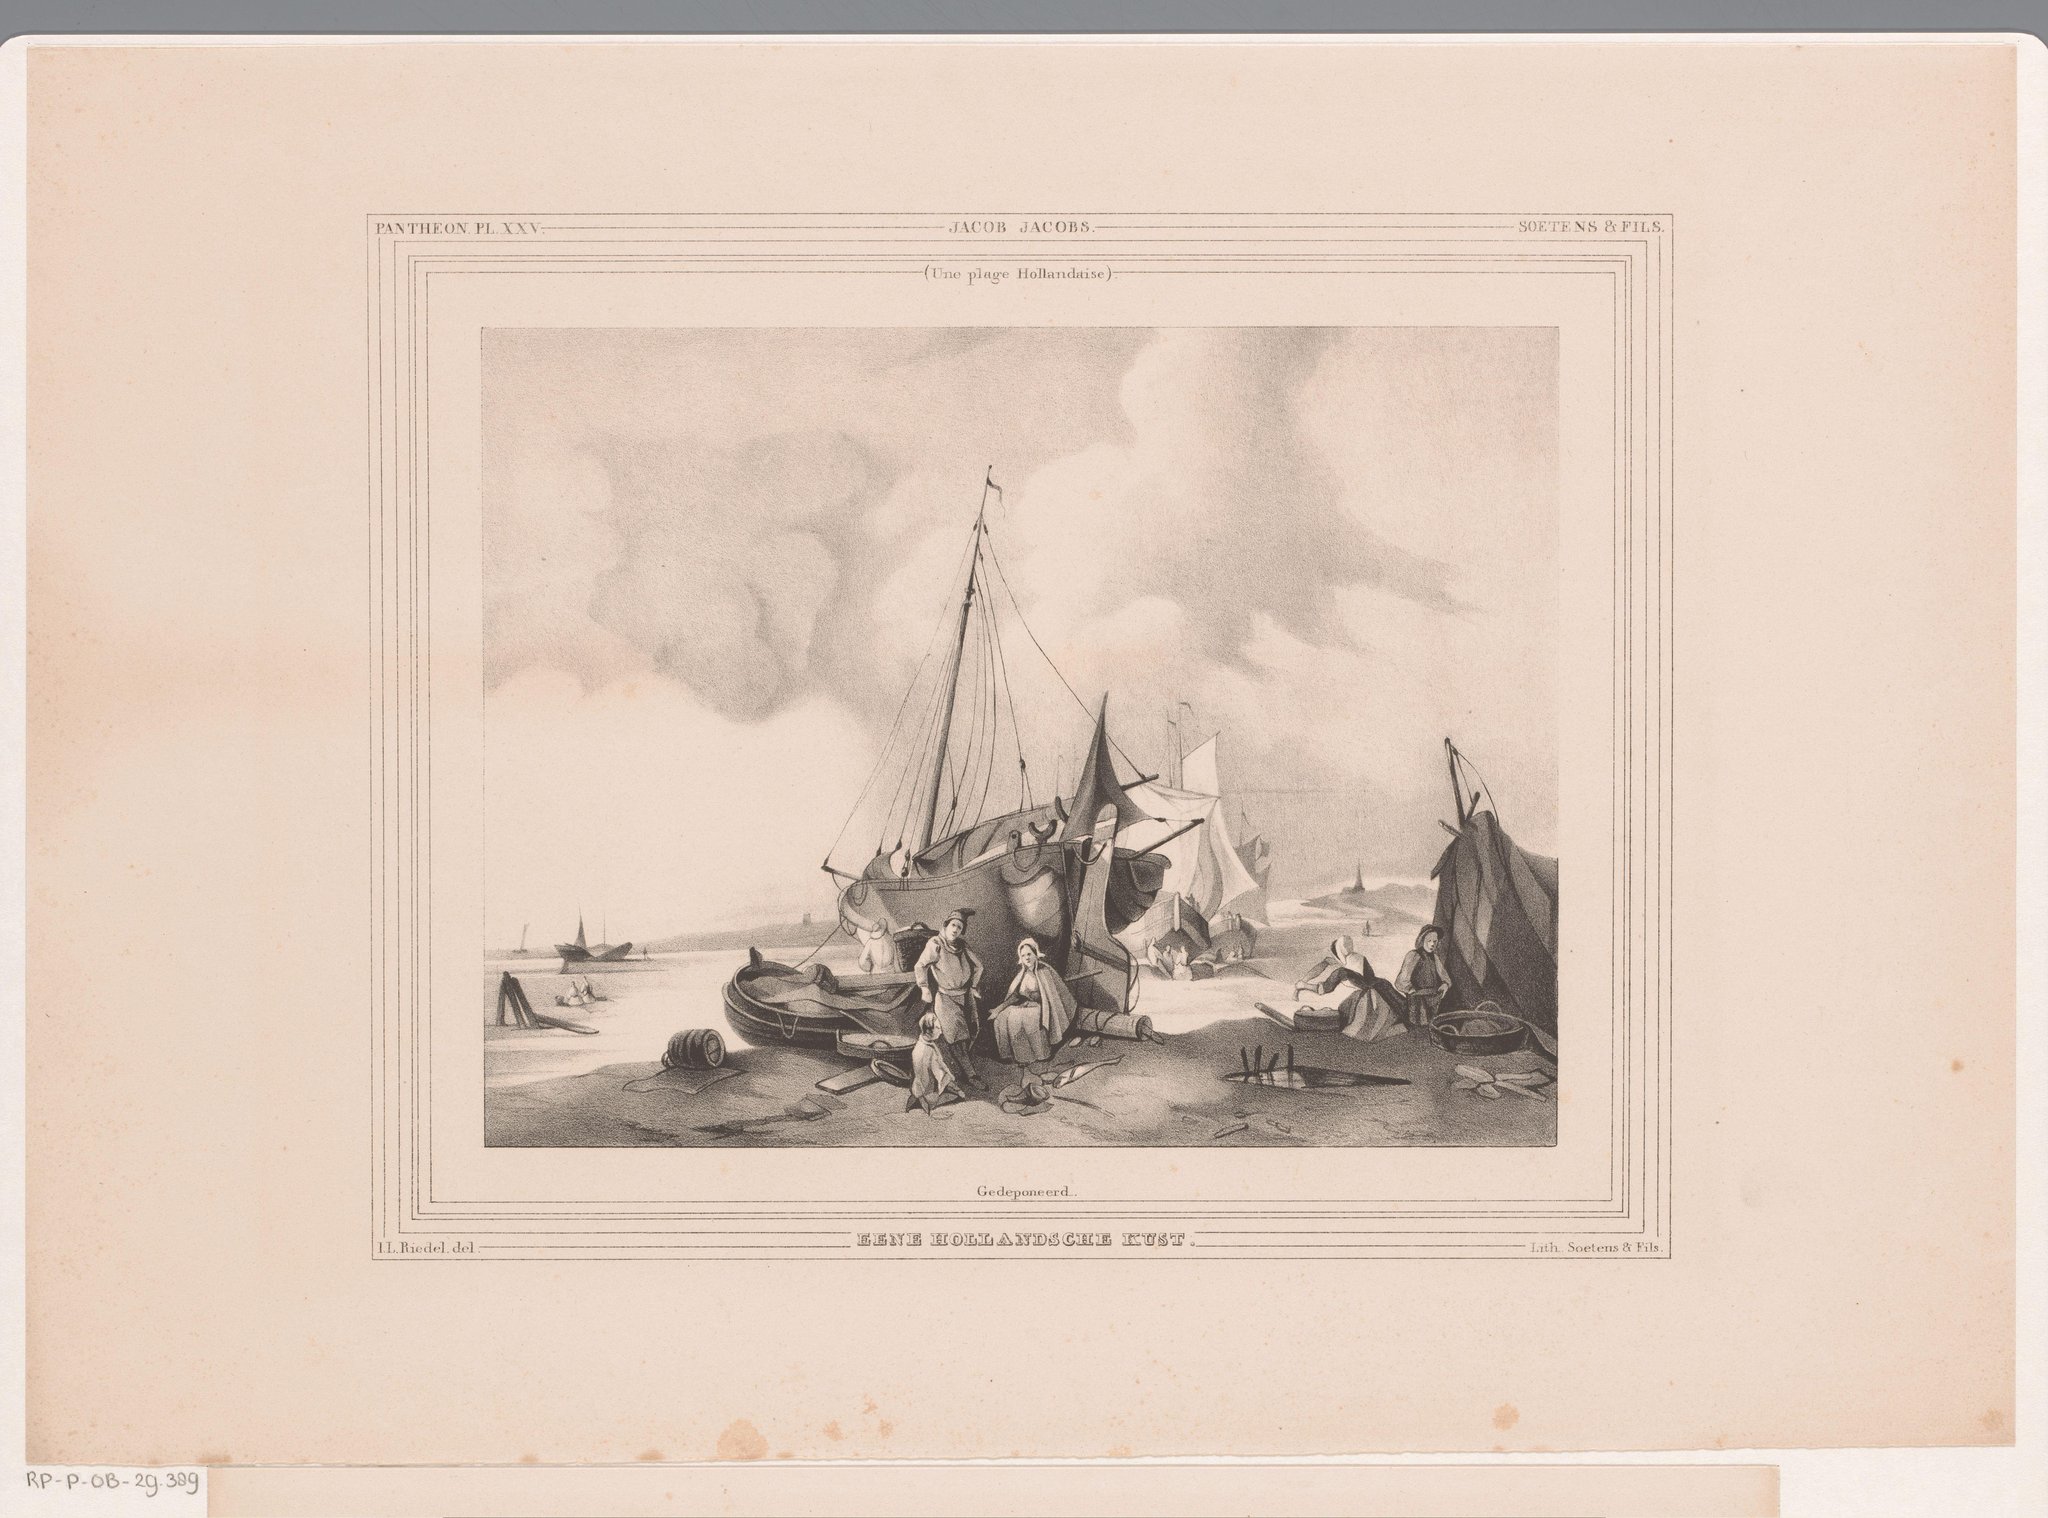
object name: print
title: Eene Hollandsche kust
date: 1837-1840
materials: paper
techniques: lithograph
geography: the hague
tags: coast, netherlands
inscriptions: collector's mark: Lugt 2228, : ‘Gedeponeerd.’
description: Langs de kust zitten figuren bij boten op het strand.